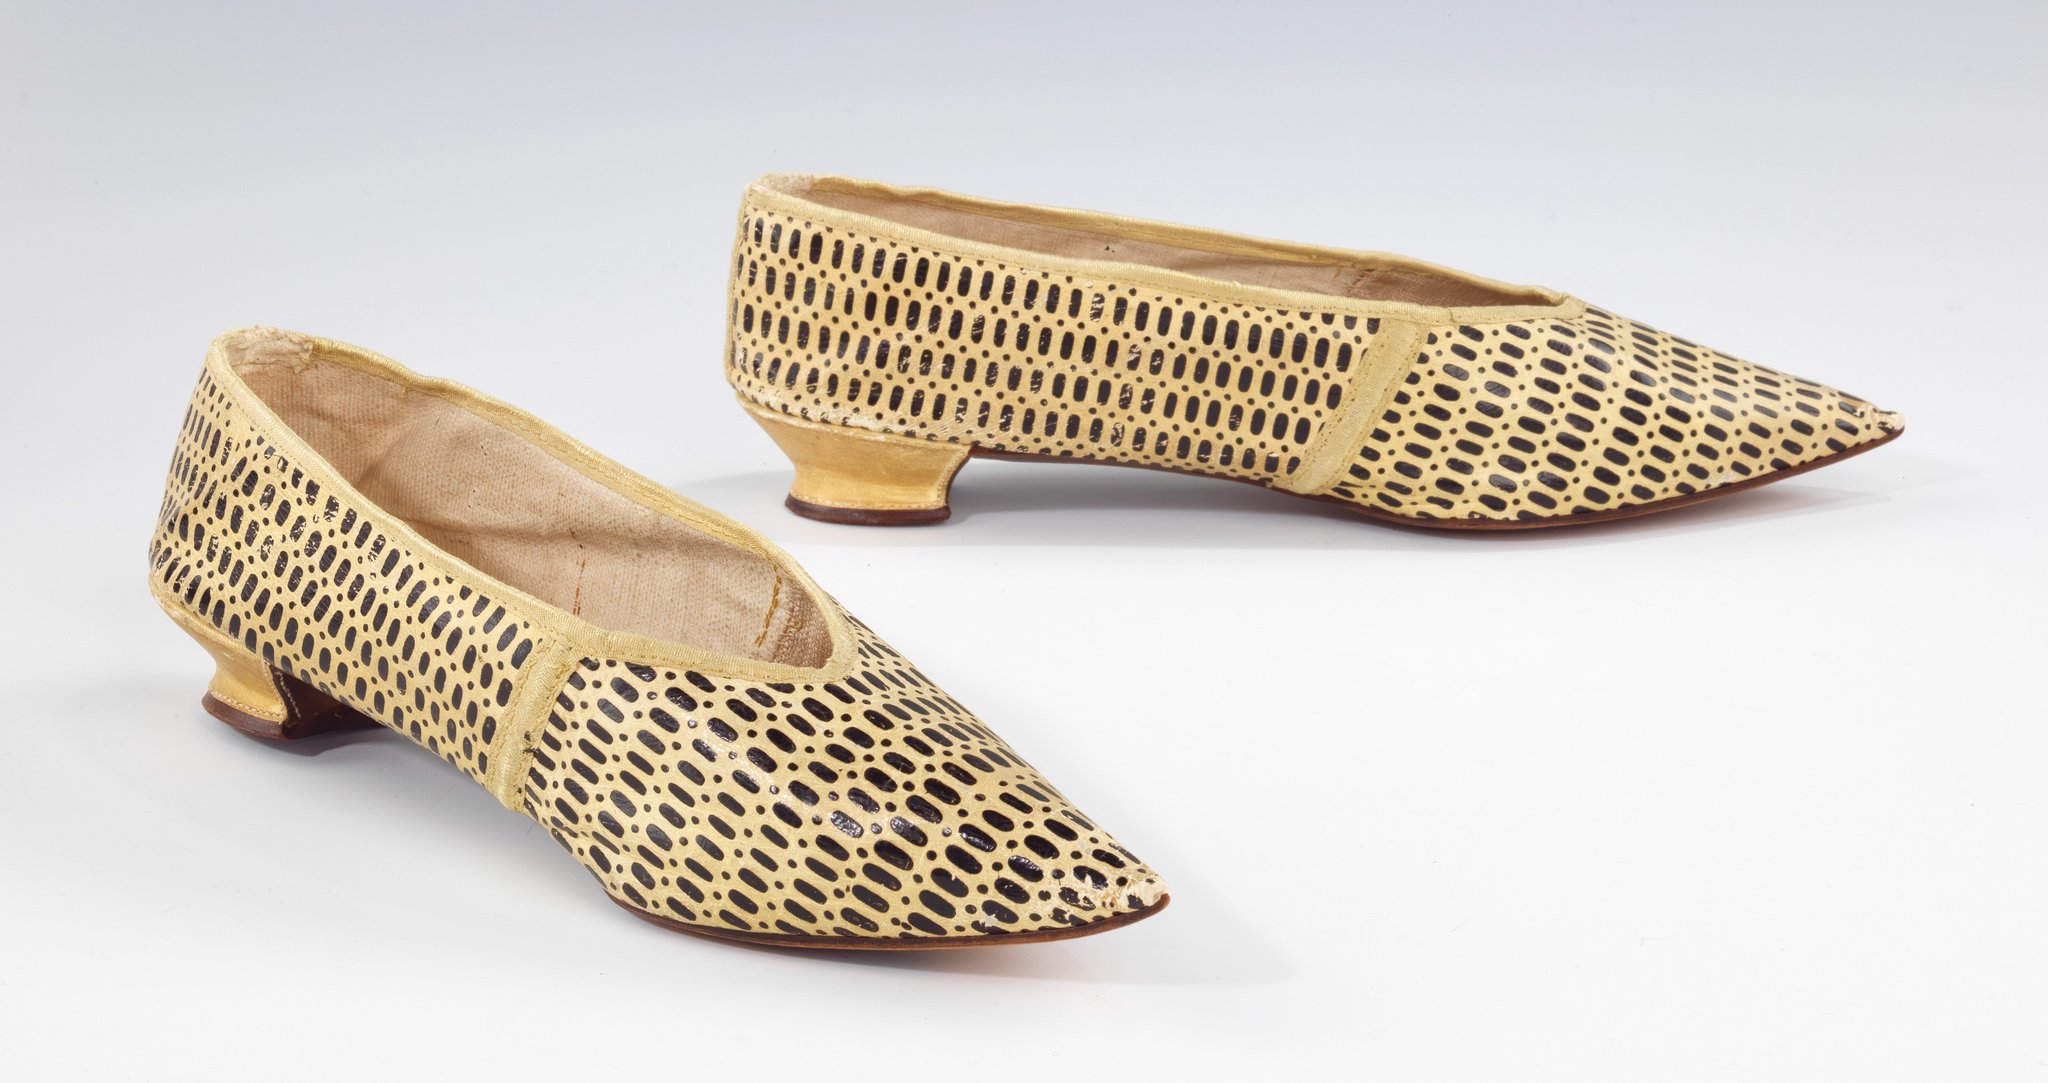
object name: slipper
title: Slippers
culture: british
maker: j. staton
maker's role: department store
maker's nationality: british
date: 1795-1805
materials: leather